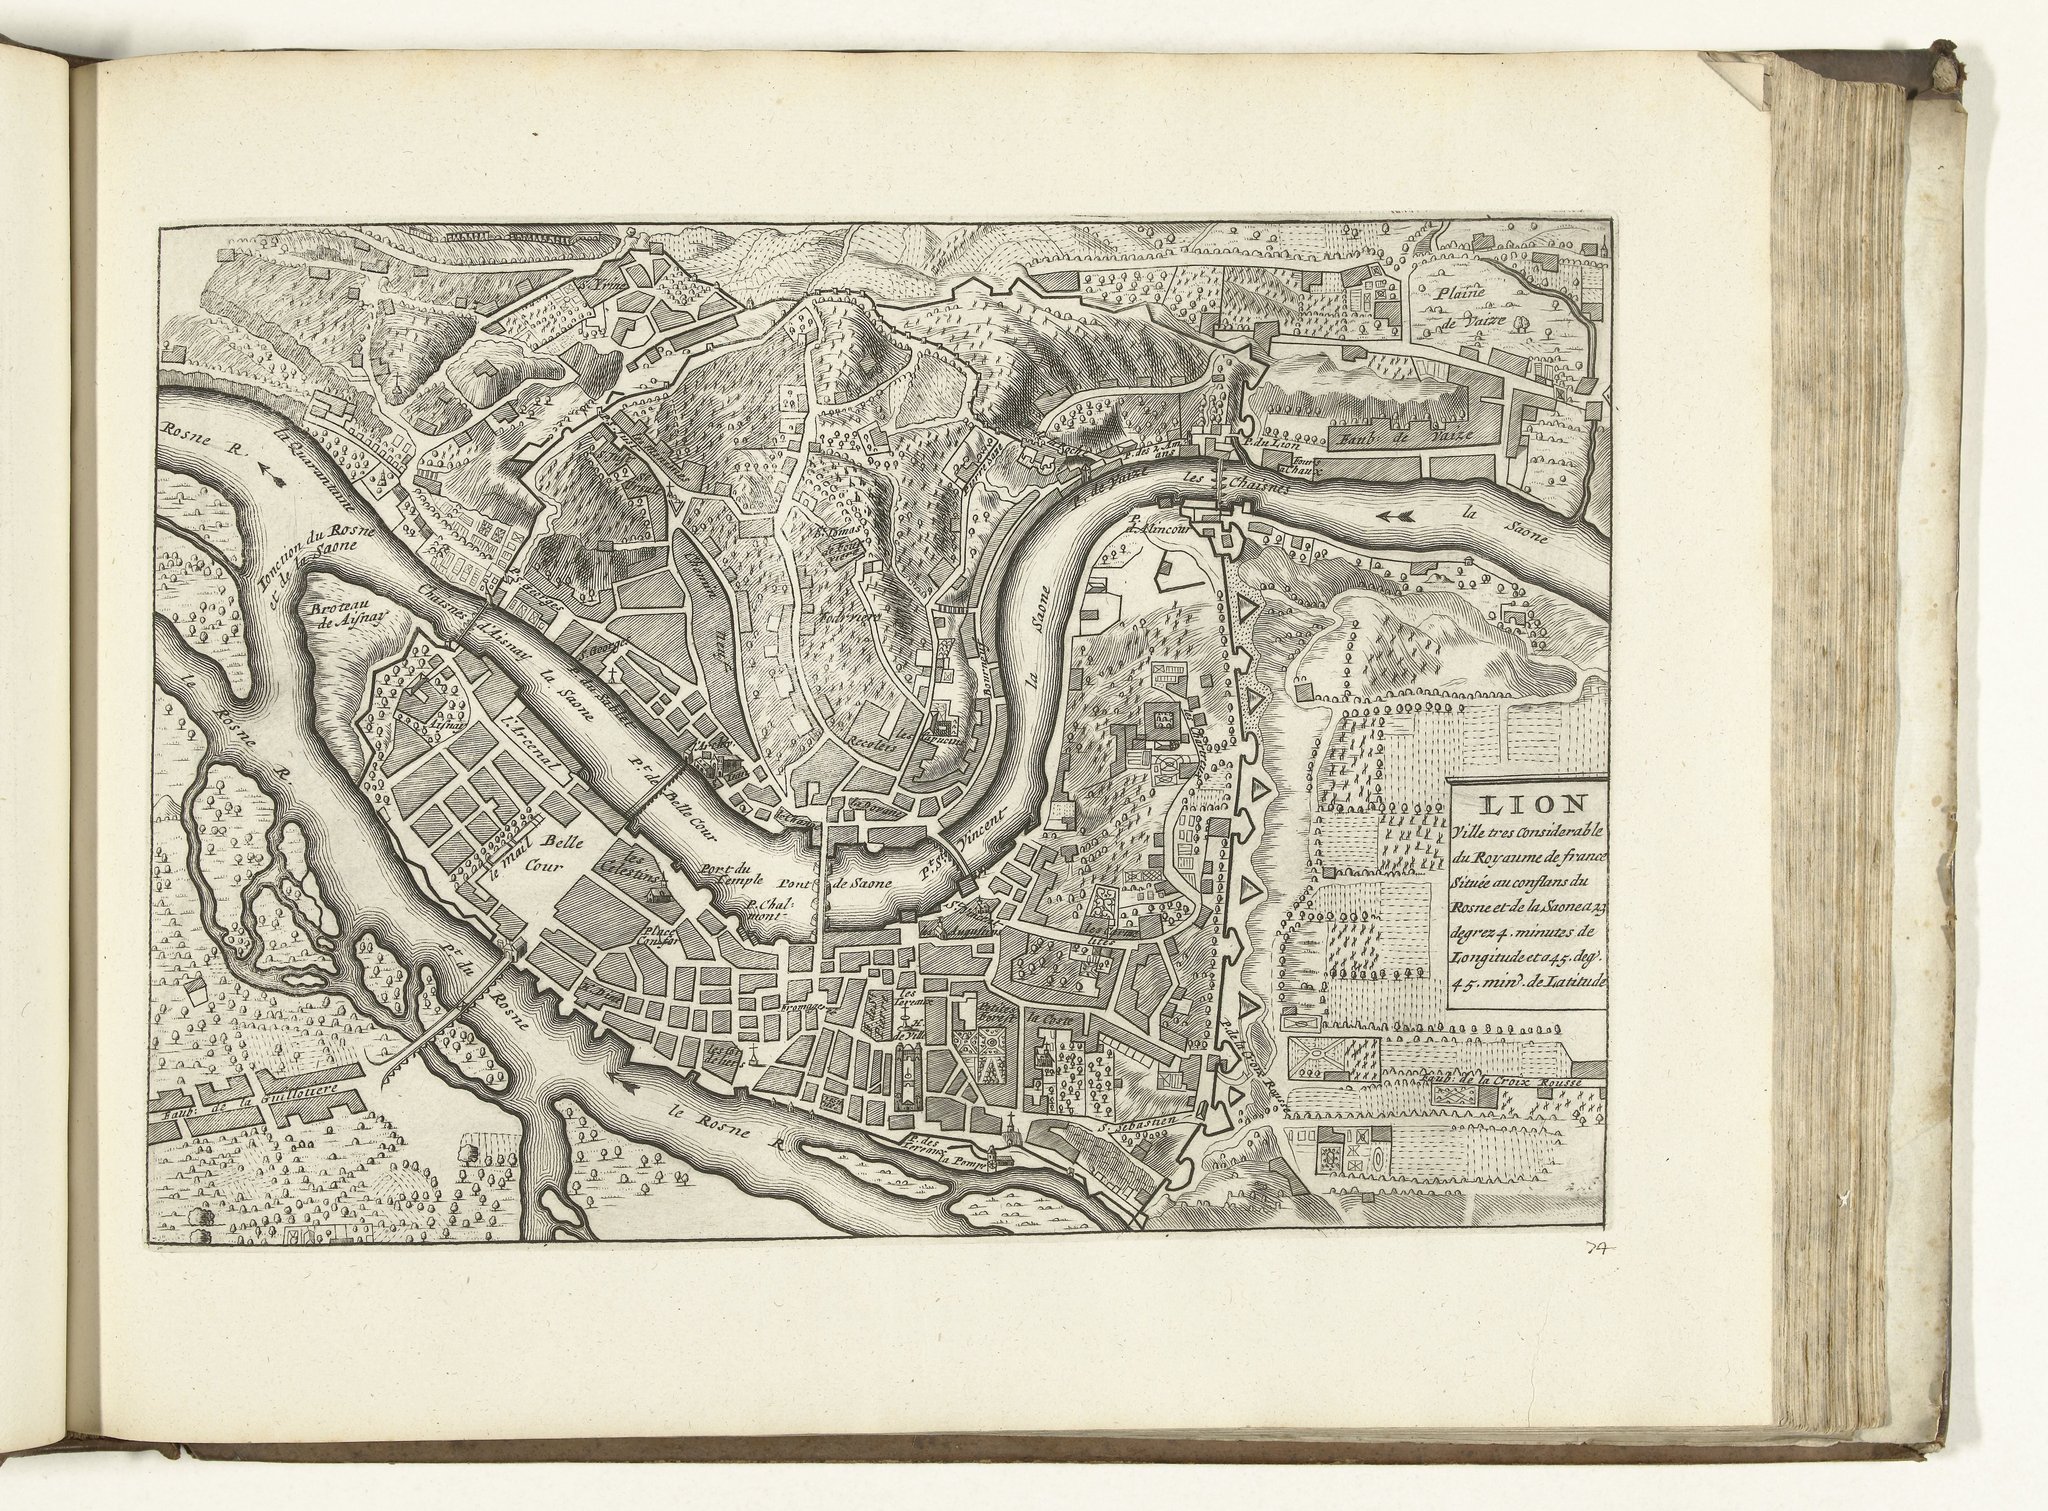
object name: print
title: Les Forces de l'Europe, Asie, Afrique et Amerique (...) Comme aussi les Cartes des Côtes de France et d'Espagne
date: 1726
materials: paper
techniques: engraving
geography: leiden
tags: maps of separate countries or regions, lyon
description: Plattegrond van de Franse stad Lyon. Plaat nr. 74 in deel IV van het prentwerk: Les Forces de l'Europe, Asie, Afrique et Amerique ... Comme aussi les Cartes des Côtes de France et d'Espagne uit 1726, dit eerste deel met 238 met de hand genummerde platen van vermaarde sterke steden en vestingen in het kader van de Spaanse Successieoorlog 1701-1713. Voor het merendeel zijn deze platen gekopieerd naar de anonieme Franse platen van vermaarde sterke steden en vestingen: in Les forces de l'Europe en in: Le theatre de la guerre, dans les Pays-Bas, beide oorspronkelijk uitgegeven door Nicolas de Fer te Parijs (1693-1697) in het kader van de Negenjarige Oorlog. Titel en opschriften in het Frans. Rechtsonder sporen van het weggepolijste nummer: 226.